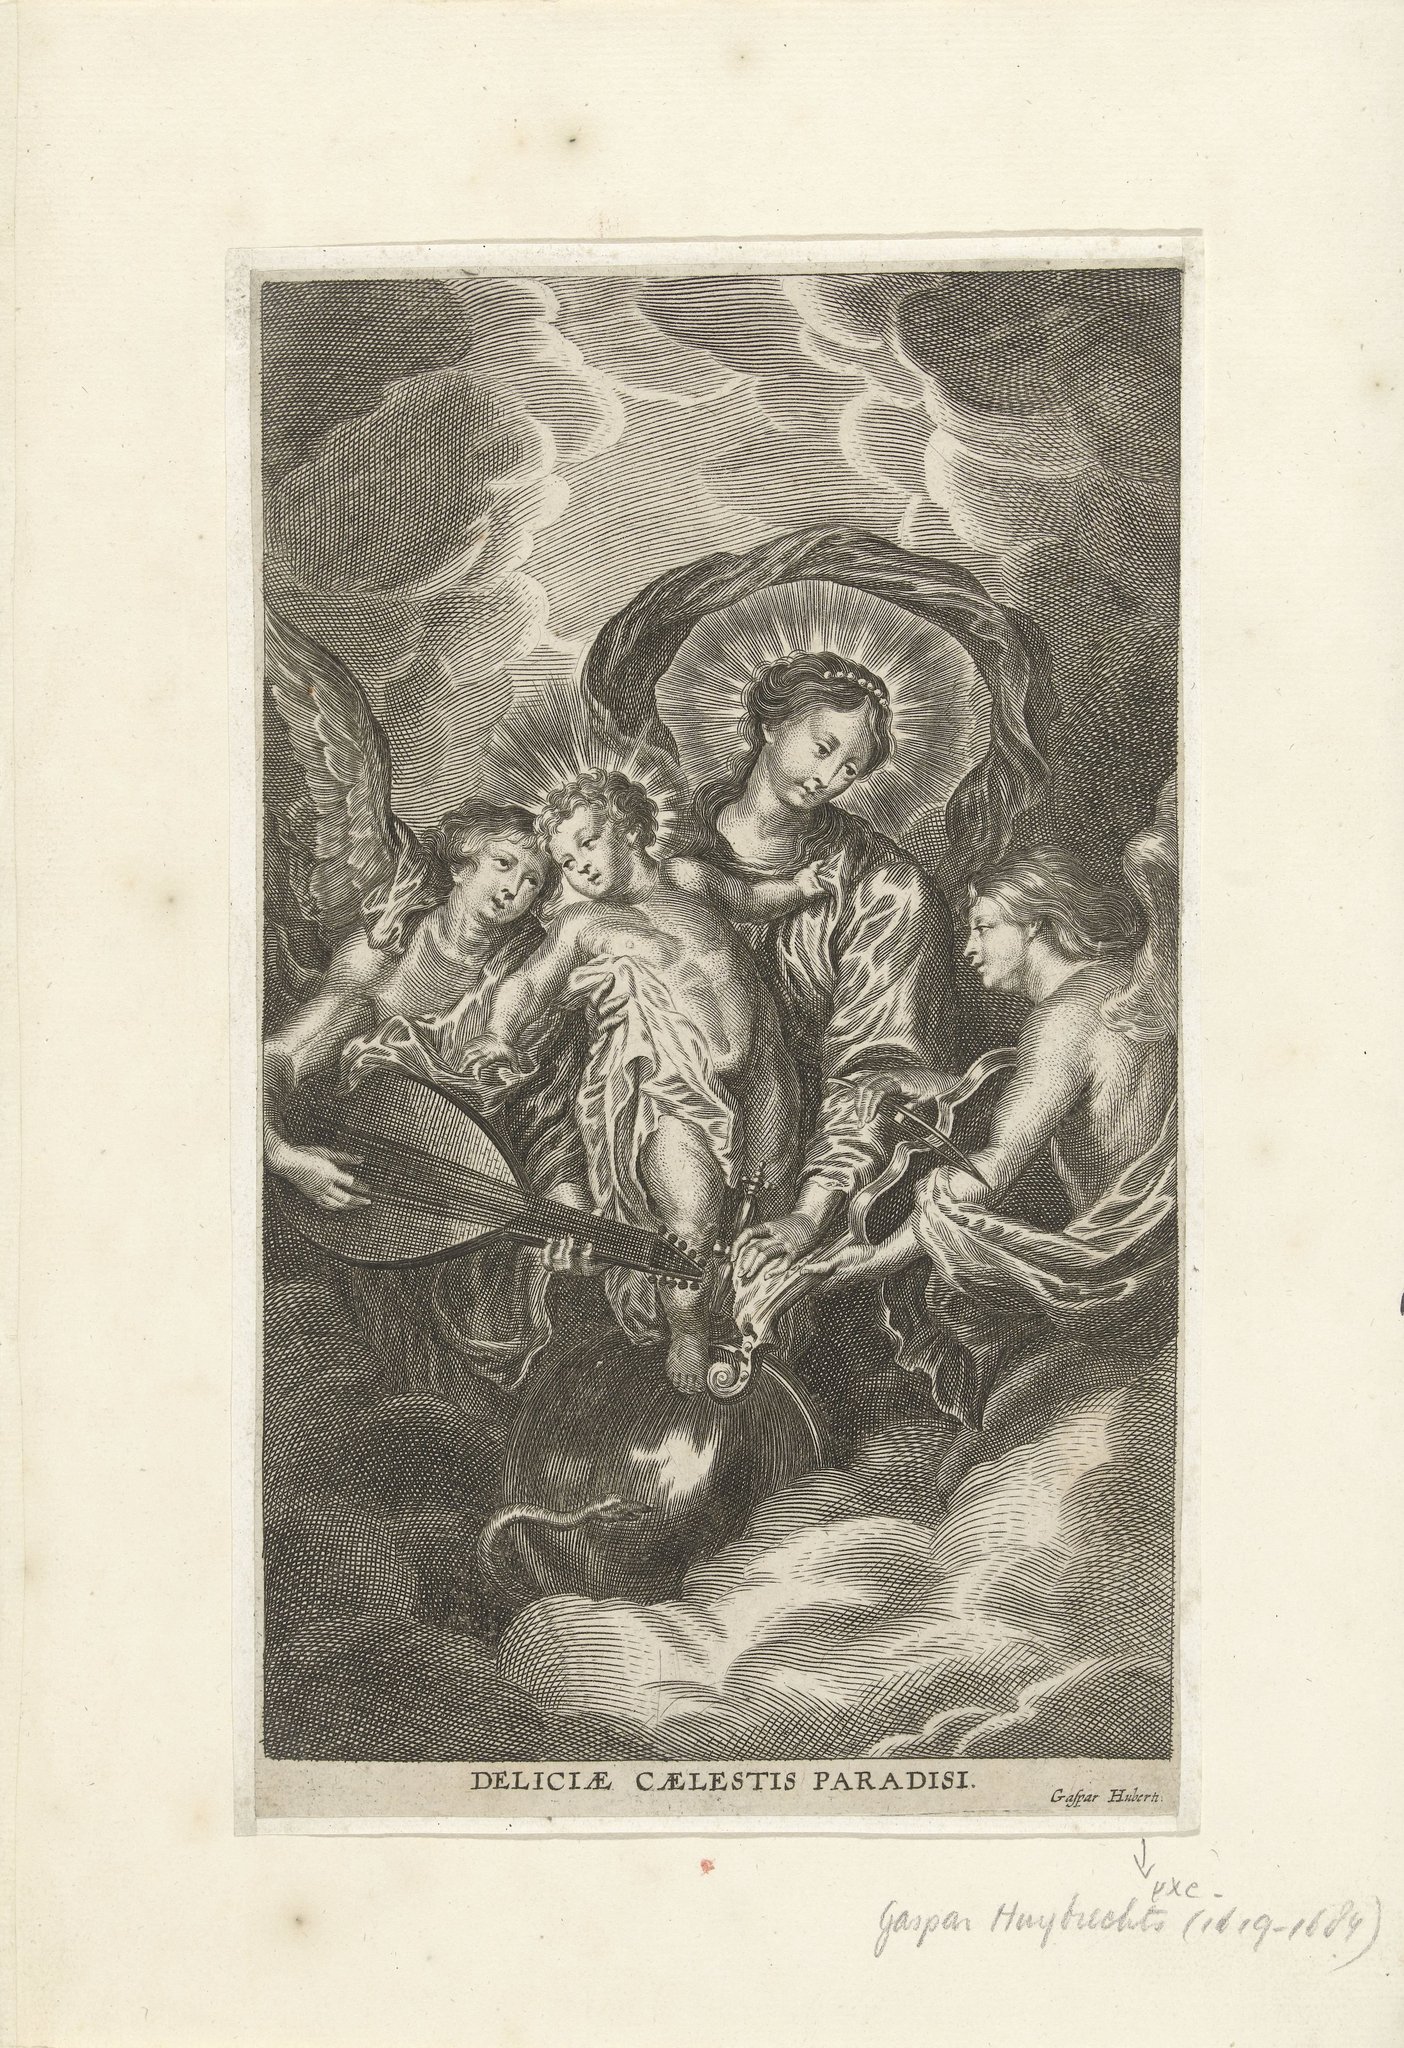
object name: print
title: Maria met Christuskind en engelen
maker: gaspar huybrechts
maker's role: print maker, publisher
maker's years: 1619-1684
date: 1661-1684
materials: paper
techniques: engraving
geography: antwerp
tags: madonna (i.e. mary with the christ-child) in the air, or on the clouds (+ angel(s))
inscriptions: collector's mark: Lugt 2228, caption: ‘Deliciae Caelestis Paradisi’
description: Maria met het Christuskind in de wolken, op de wereldbol, omgeven door twee musicerende engelen. Onder de wereldbol wordt de slang vertrapt.